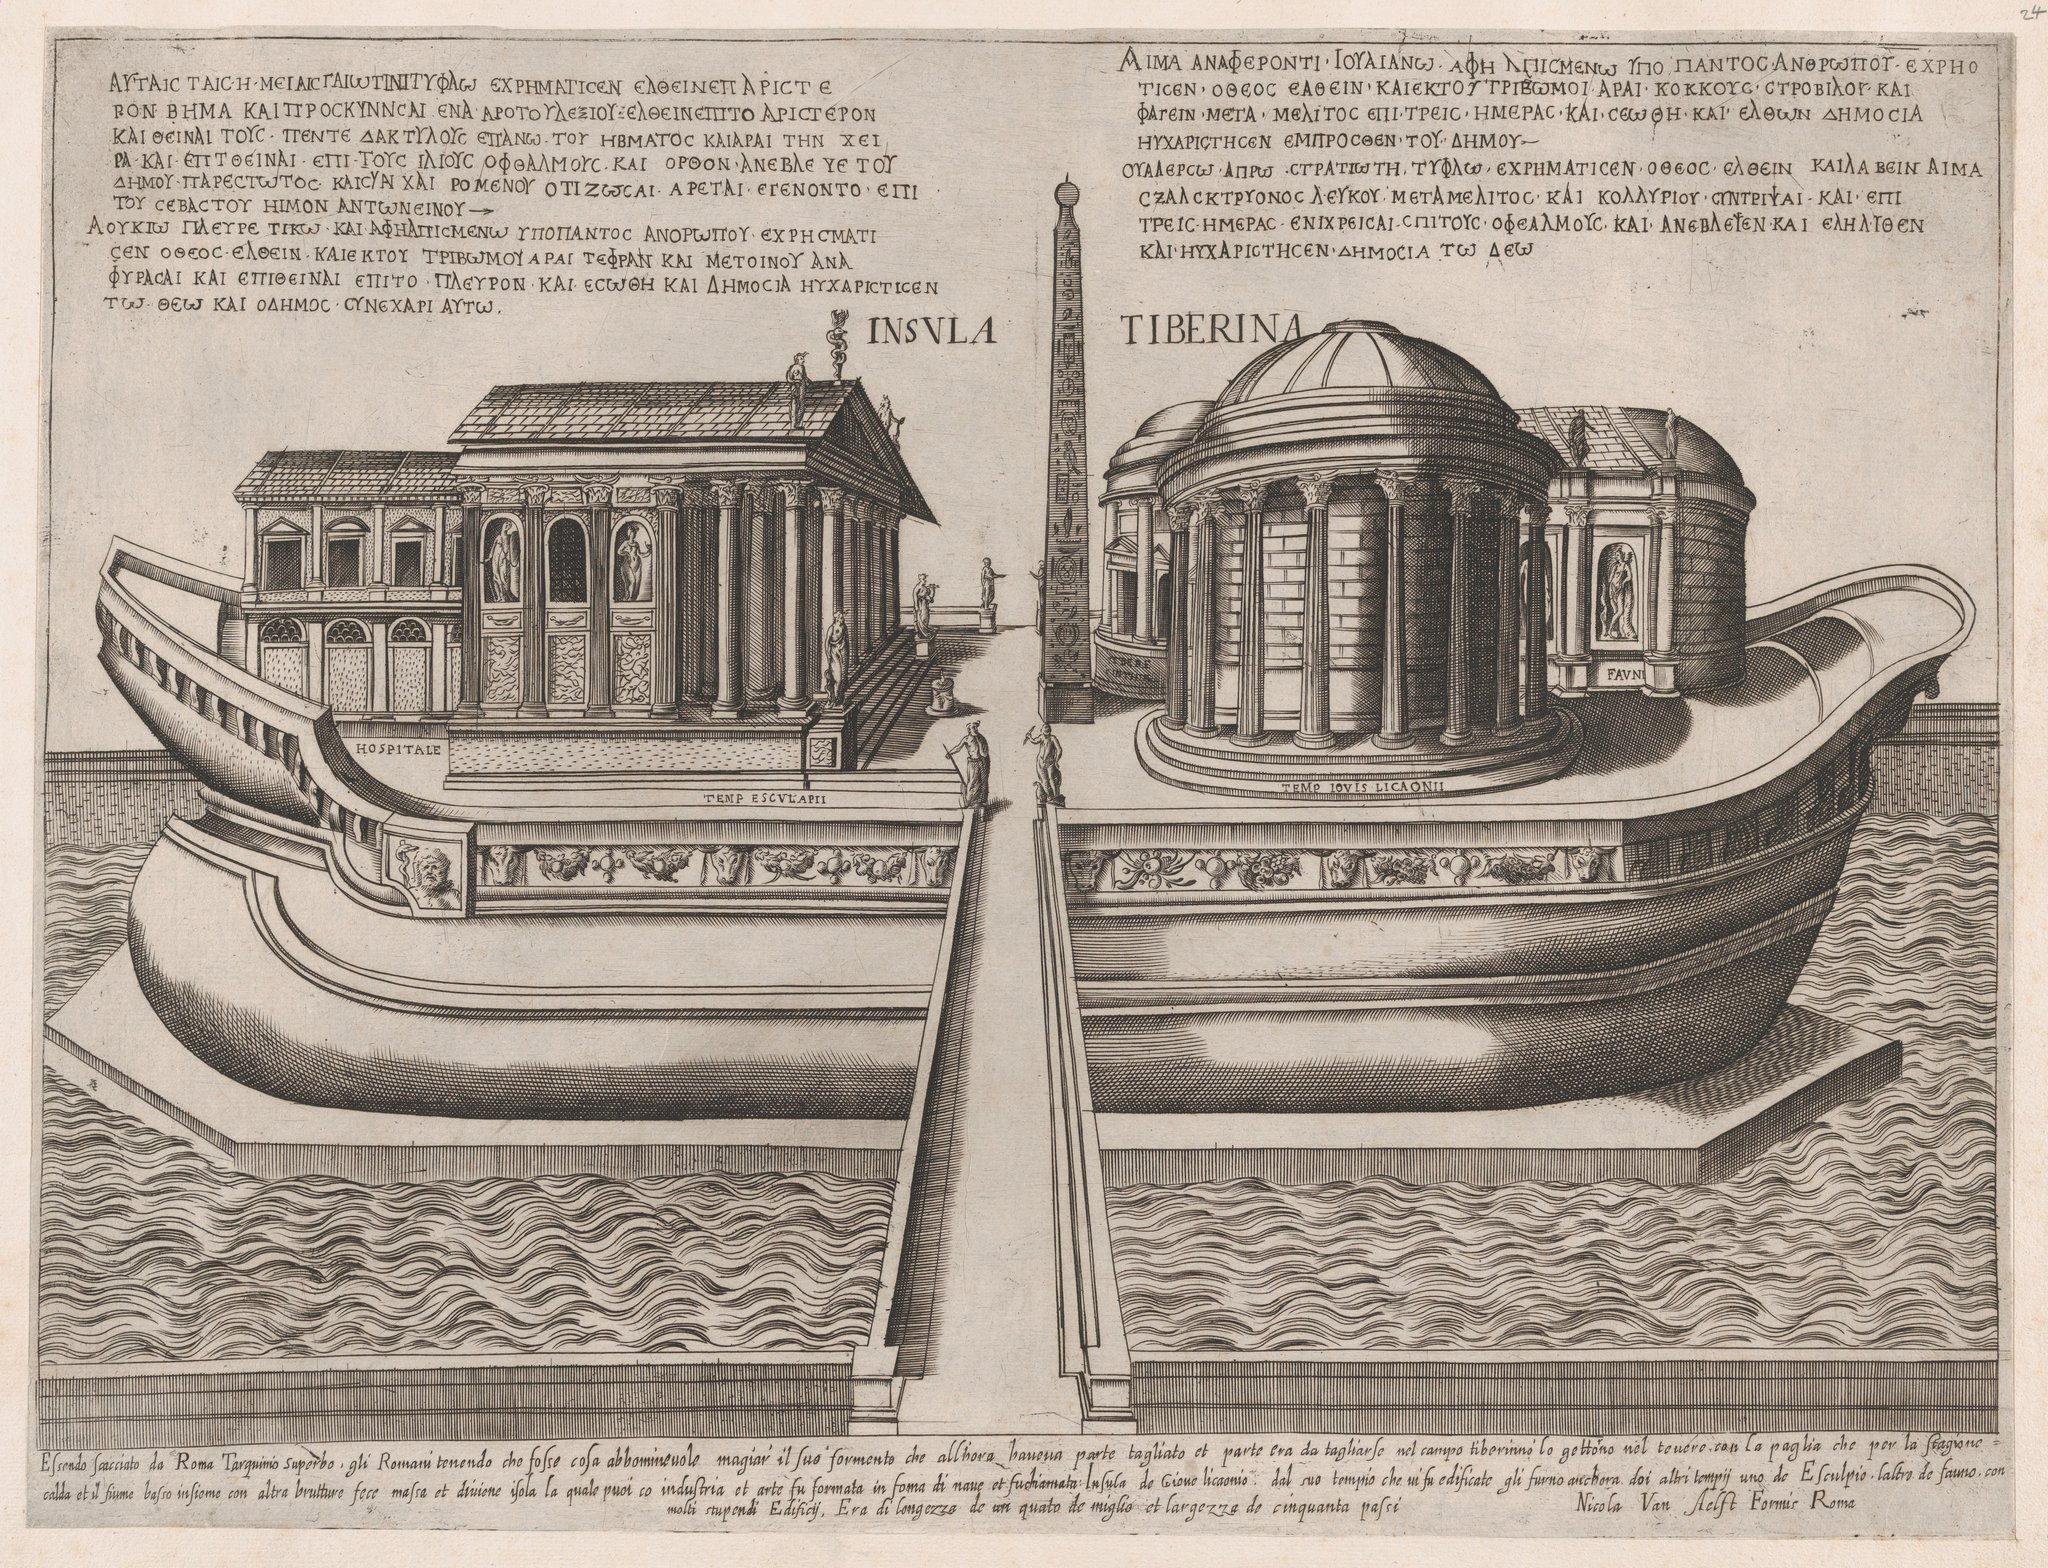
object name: print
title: Temples on the Isle of Tiber, from "Speculum Romanae Magnificentiae"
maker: Anonymous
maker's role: artist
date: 1501-1600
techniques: engraving, etching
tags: human figures,temples